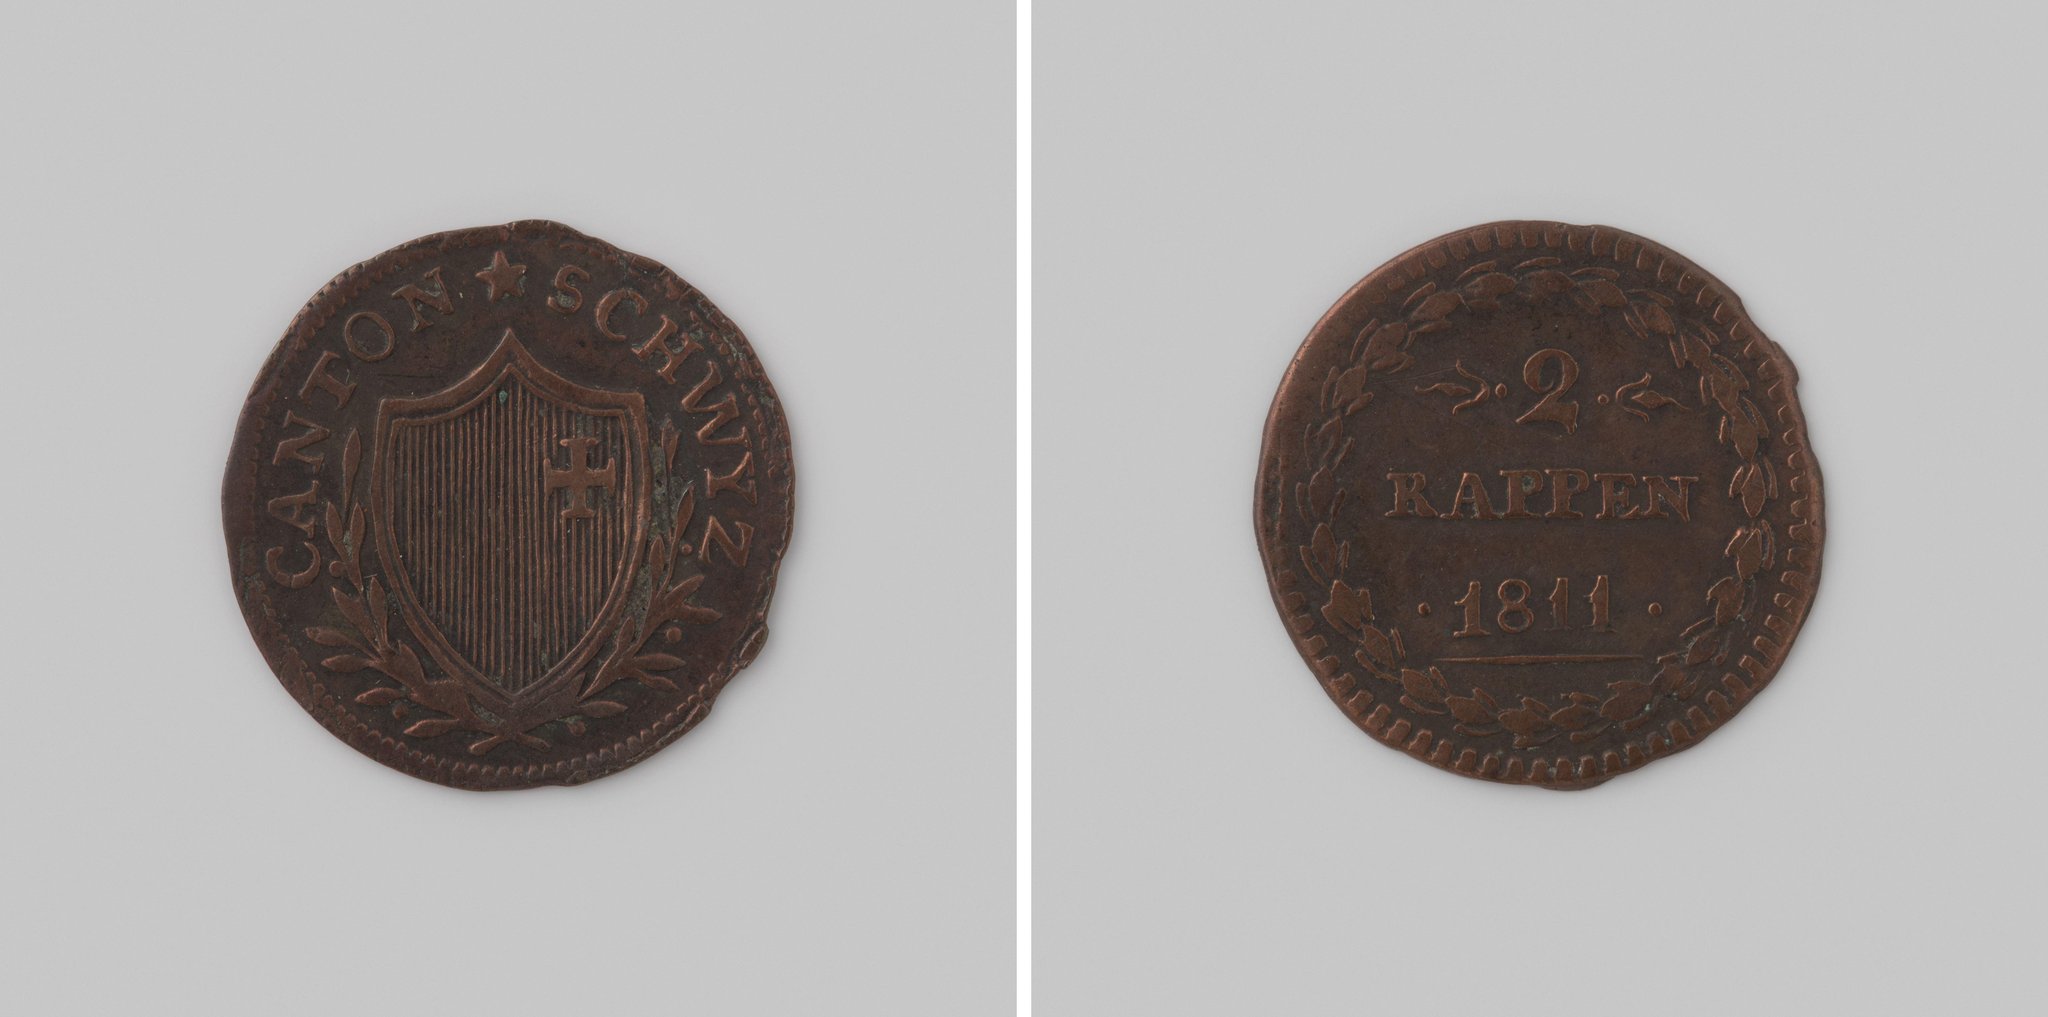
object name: coin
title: 2 rappen uit het kanton Schwyz, 1811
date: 1811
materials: copper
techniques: striking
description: Koperen munt. Voorzijde: binnen twee takken wapenschild. Keerzijde: binnen krans van bladeren in twee regels waarde-aanduiding, waaronder jaartal. Gladde rand.